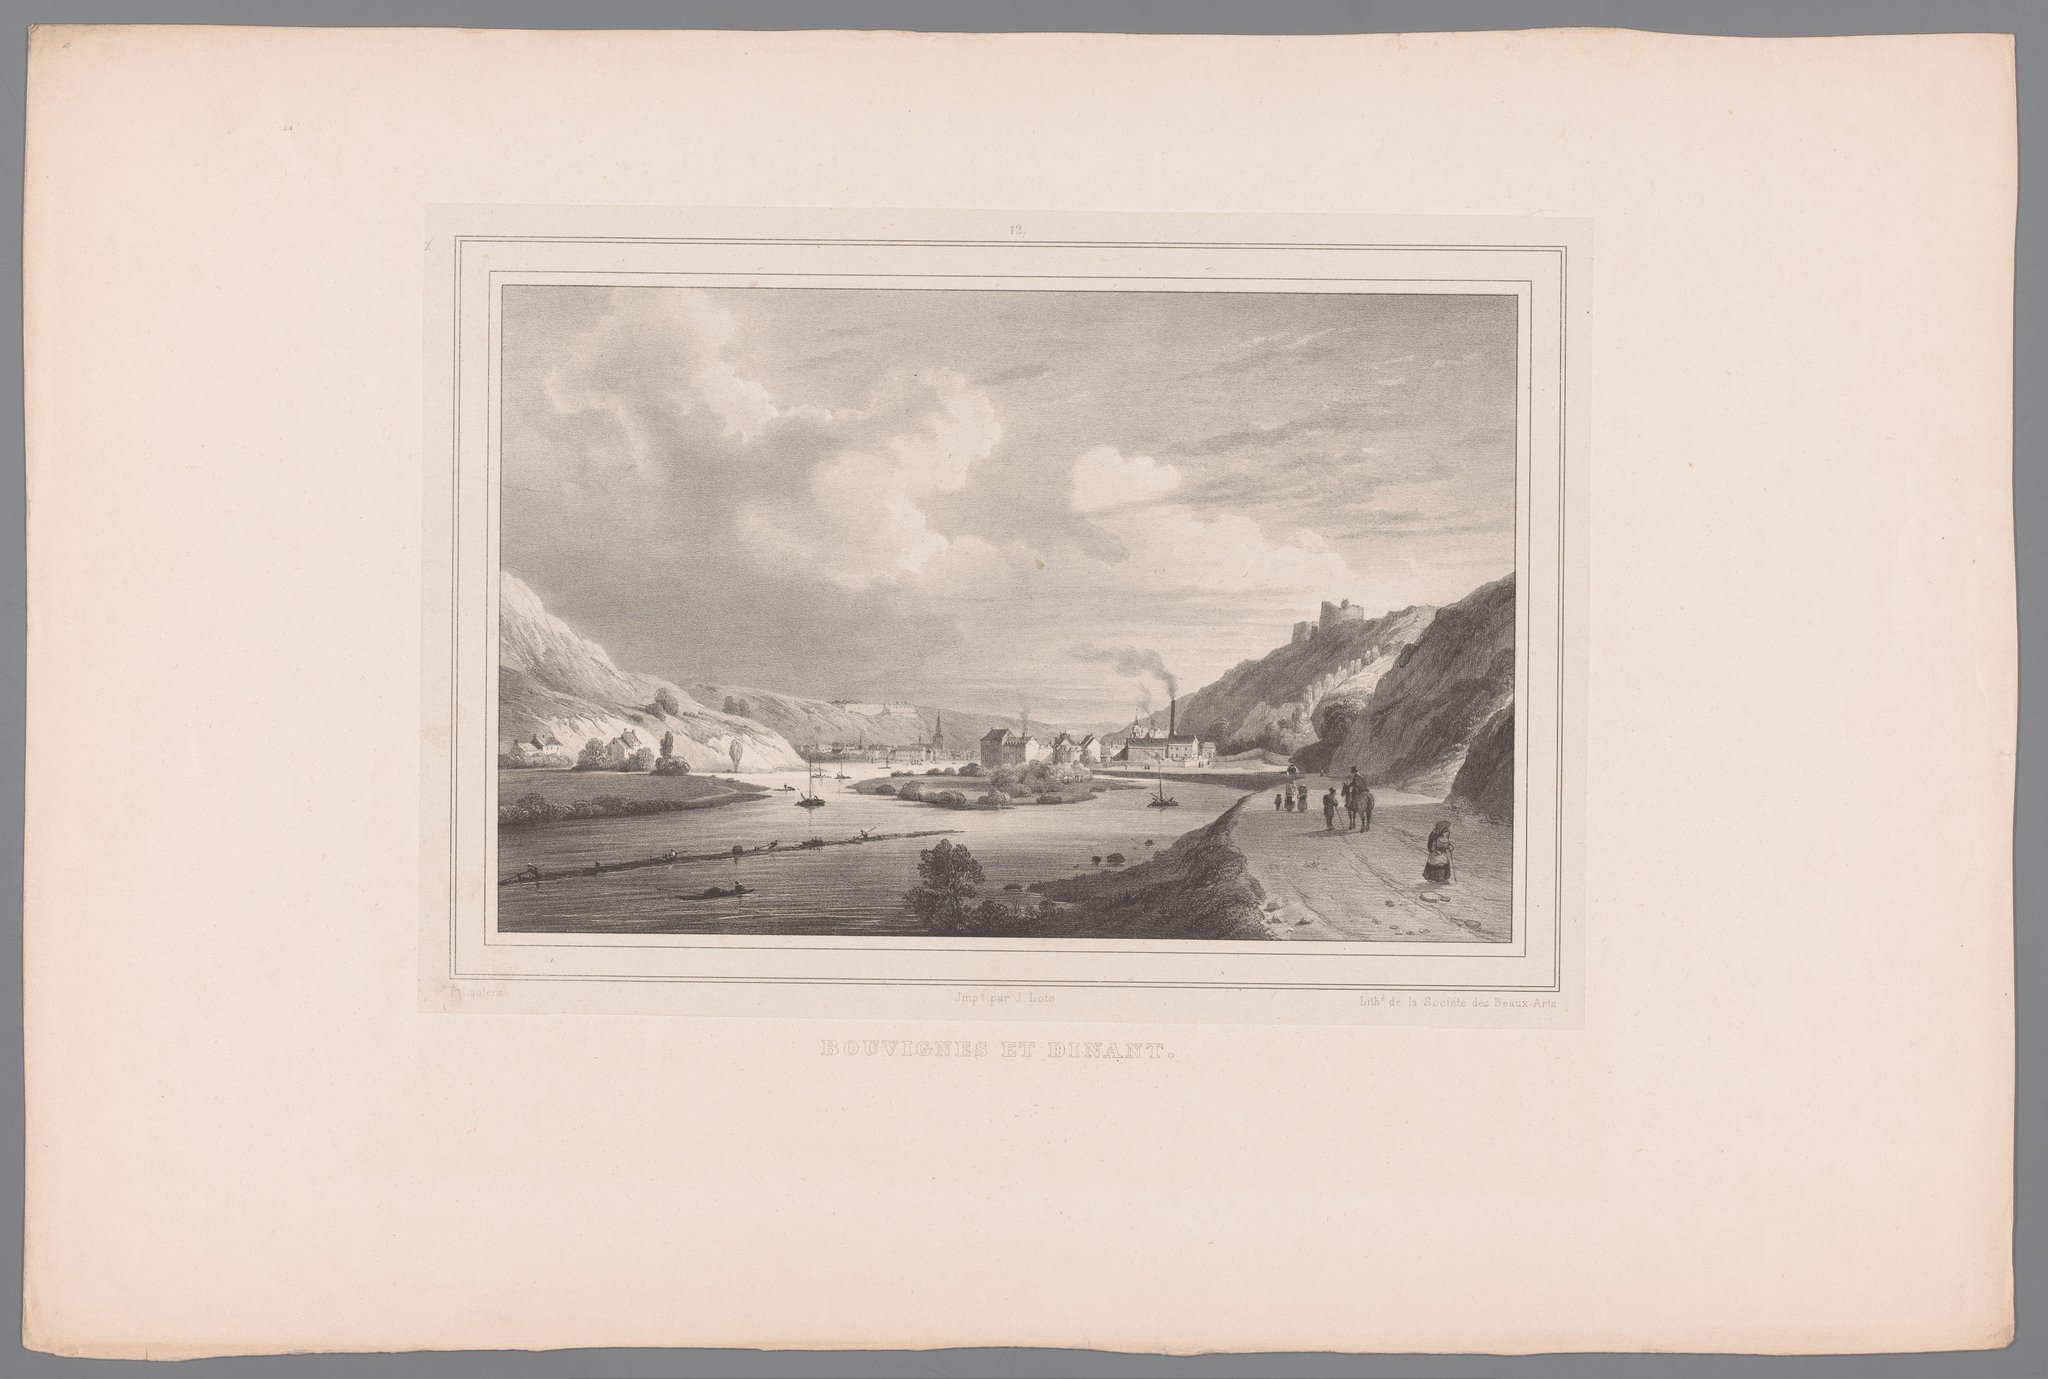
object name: print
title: Bouvignes et Dinant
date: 1839-1841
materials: paper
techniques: lithograph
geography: brussels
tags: river, prospect of city, town panorama, silhouette of city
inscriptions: collector's mark: Lugt 2228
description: Prent verschenen in: Van Hasselt, André. Voyage aux bords de la Meuse. Brussel: Société des Beaux-Arts, 1839-1841. Deze publicatie bevat 36 litho's.